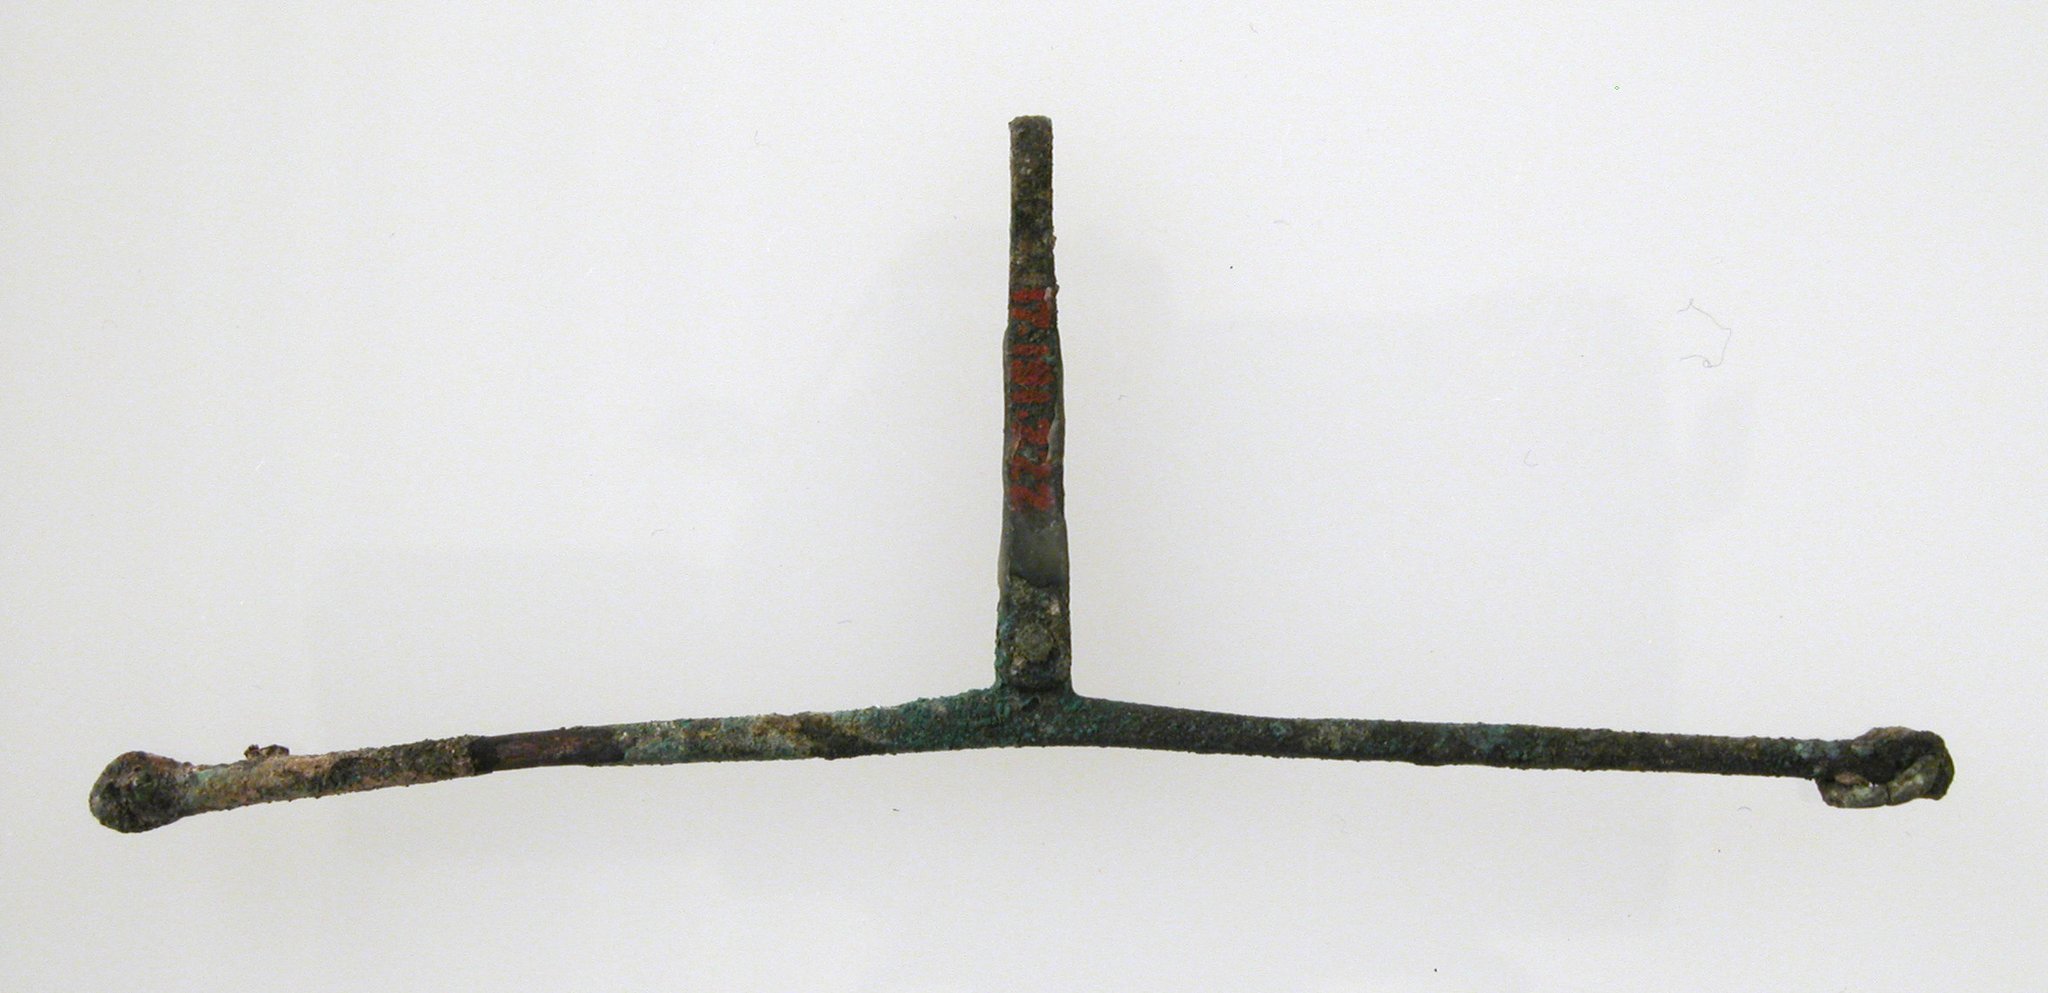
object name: scale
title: Druggist's Scales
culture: roman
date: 501-700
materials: copper alloy